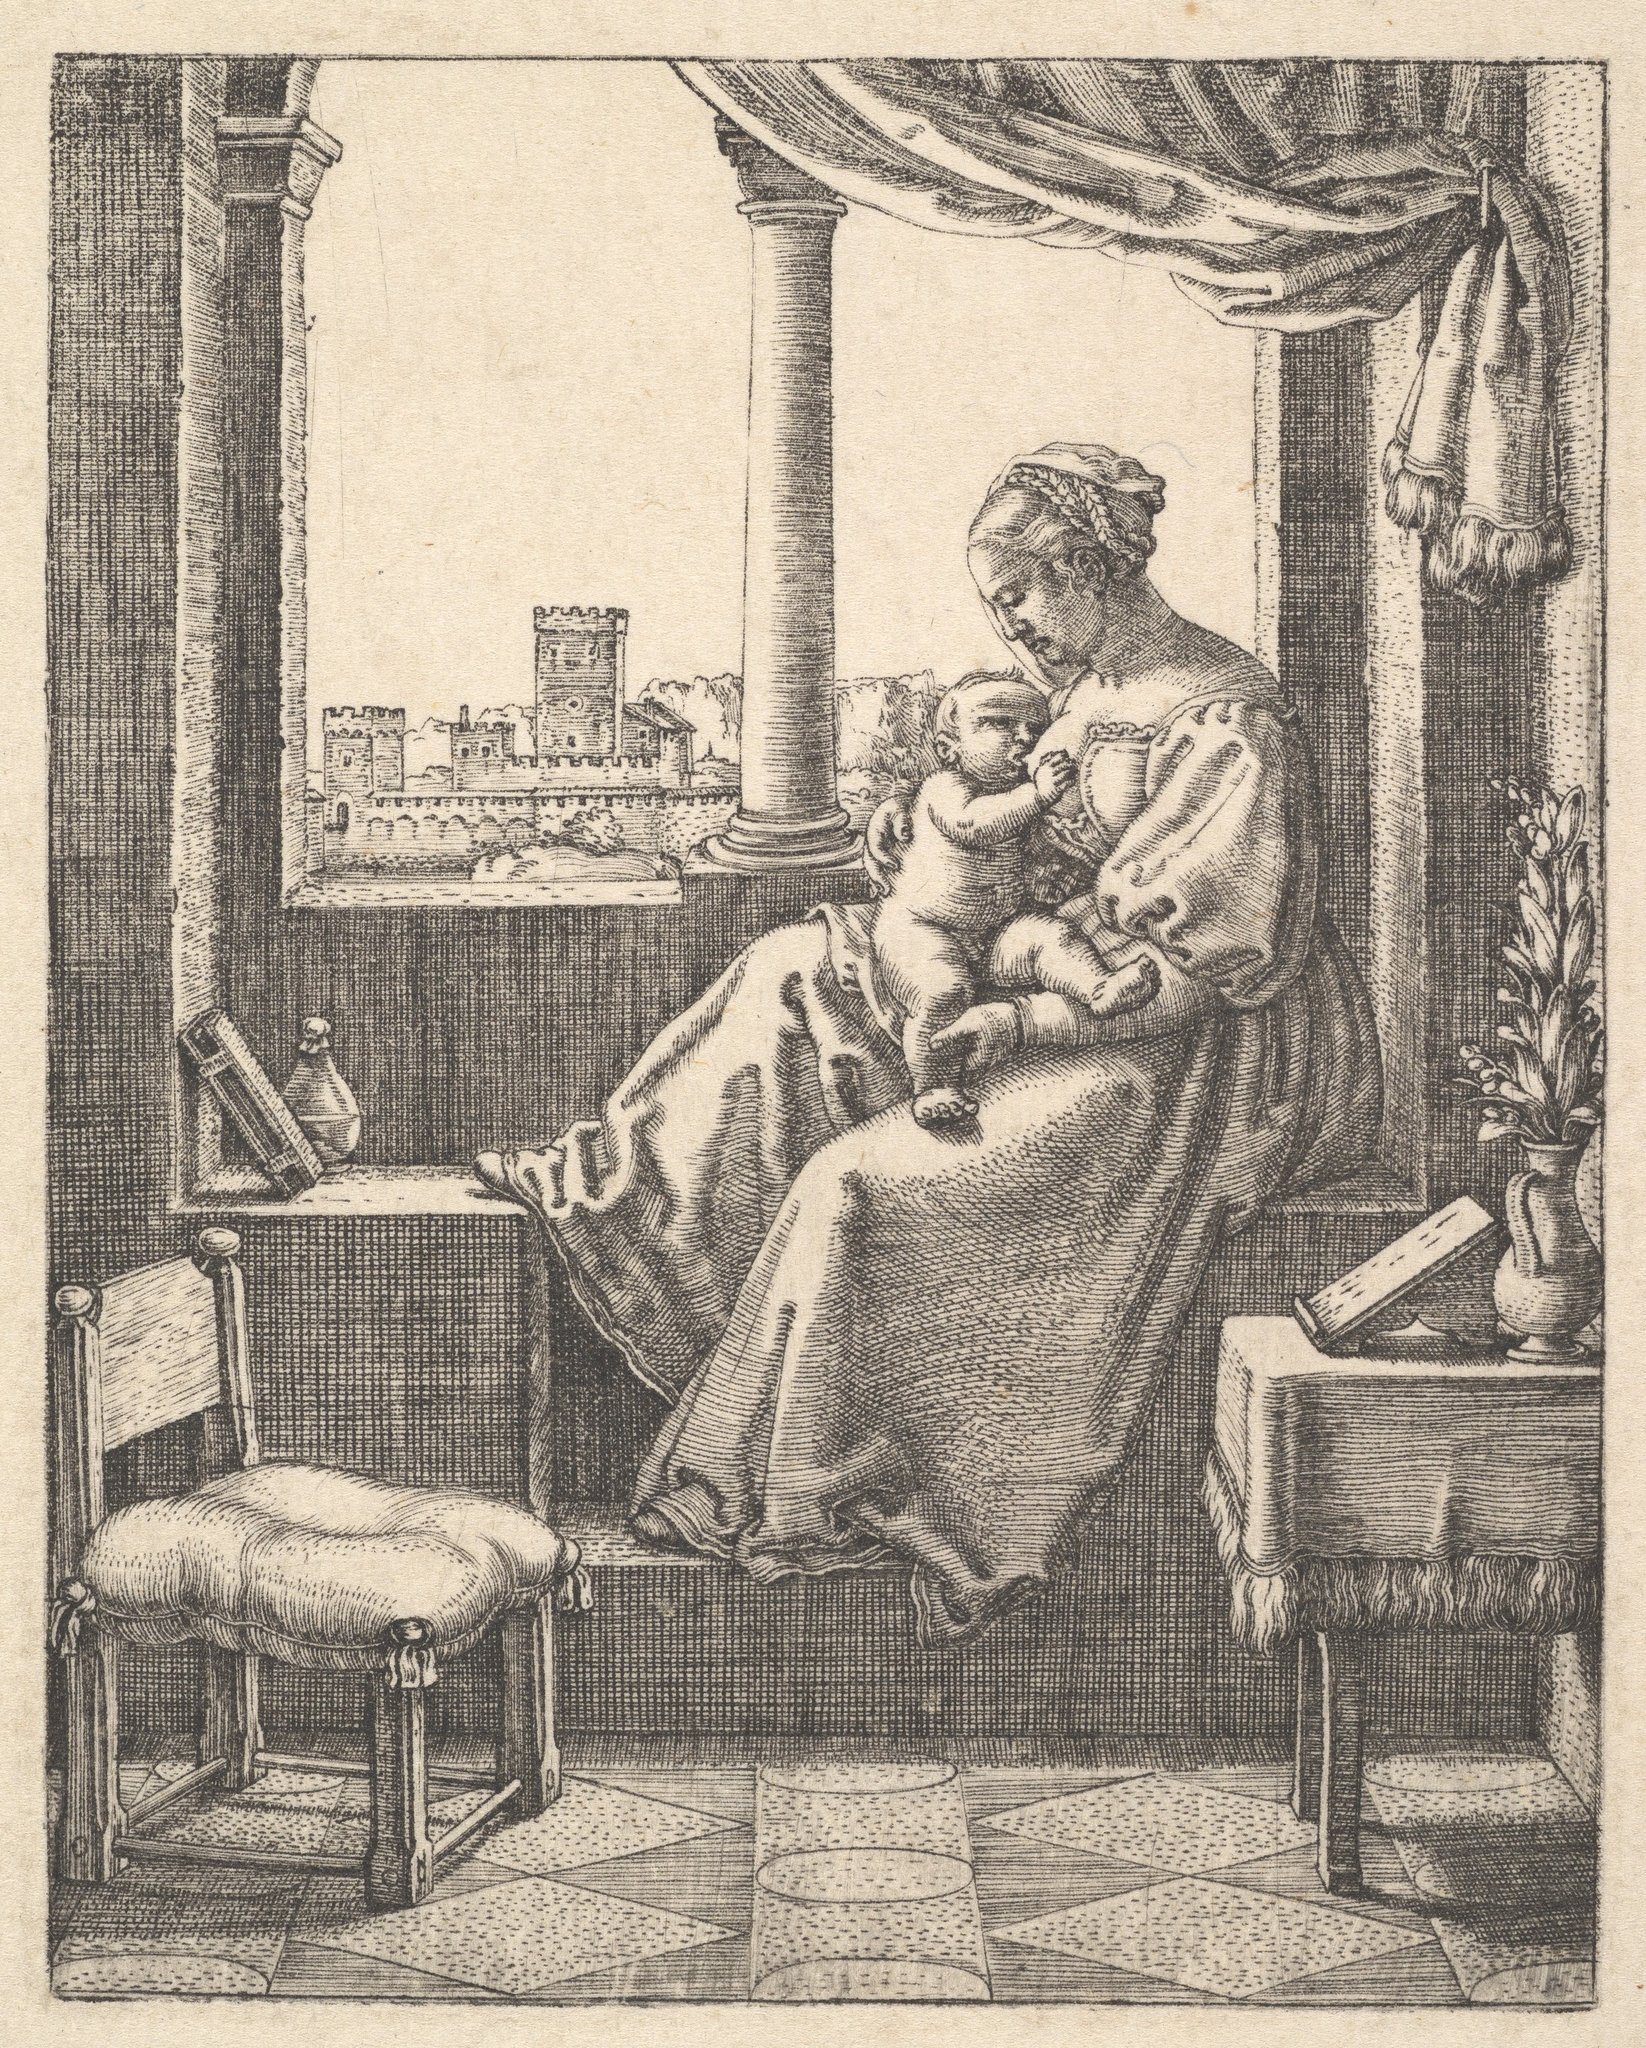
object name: print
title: The Virgin at the Window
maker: barthel beham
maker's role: artist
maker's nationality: german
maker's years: 1502-1540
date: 1502-1540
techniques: engraving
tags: windows,interiors,virgin mary,jesus,nursing